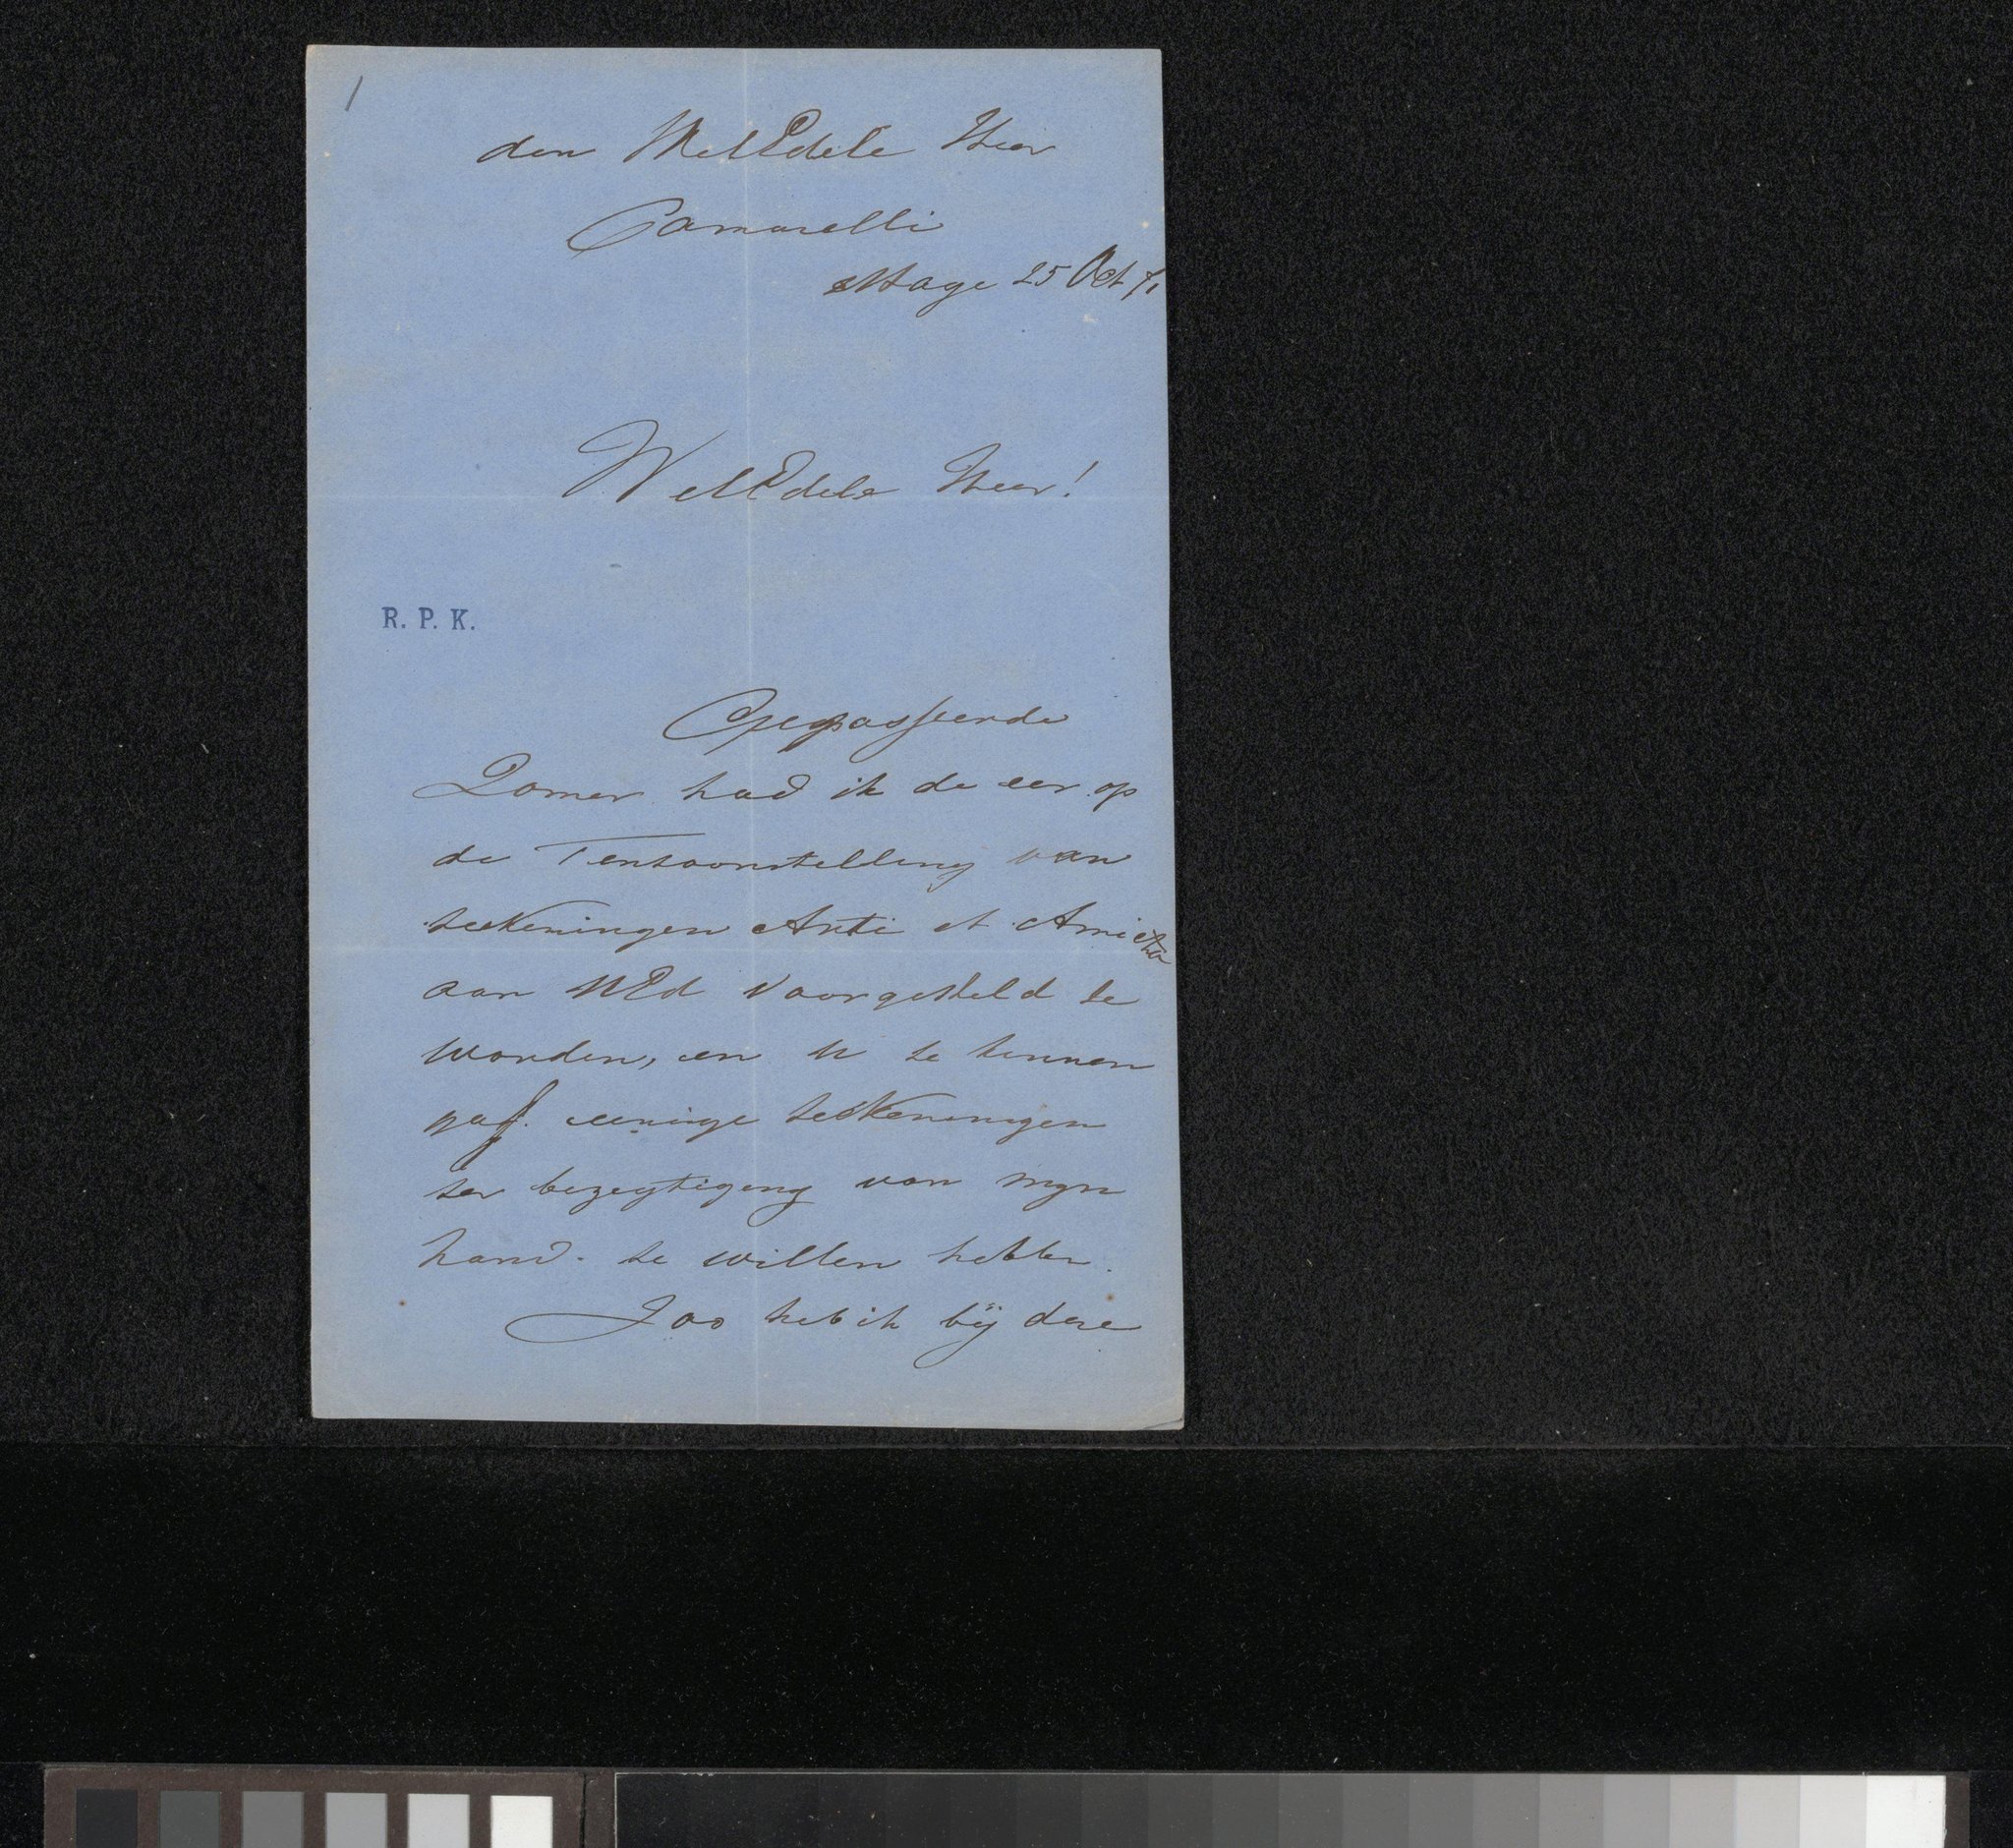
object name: letter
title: Brief aan de heer Camarelli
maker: louis apol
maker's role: draughtsman, painter, print maker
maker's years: 1850-1936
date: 1871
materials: ink, paper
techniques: pen, writing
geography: the hague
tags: art trade, art shop, the graphic arts, exhibition ~ art, money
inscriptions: collector's mark: Lugt 2233